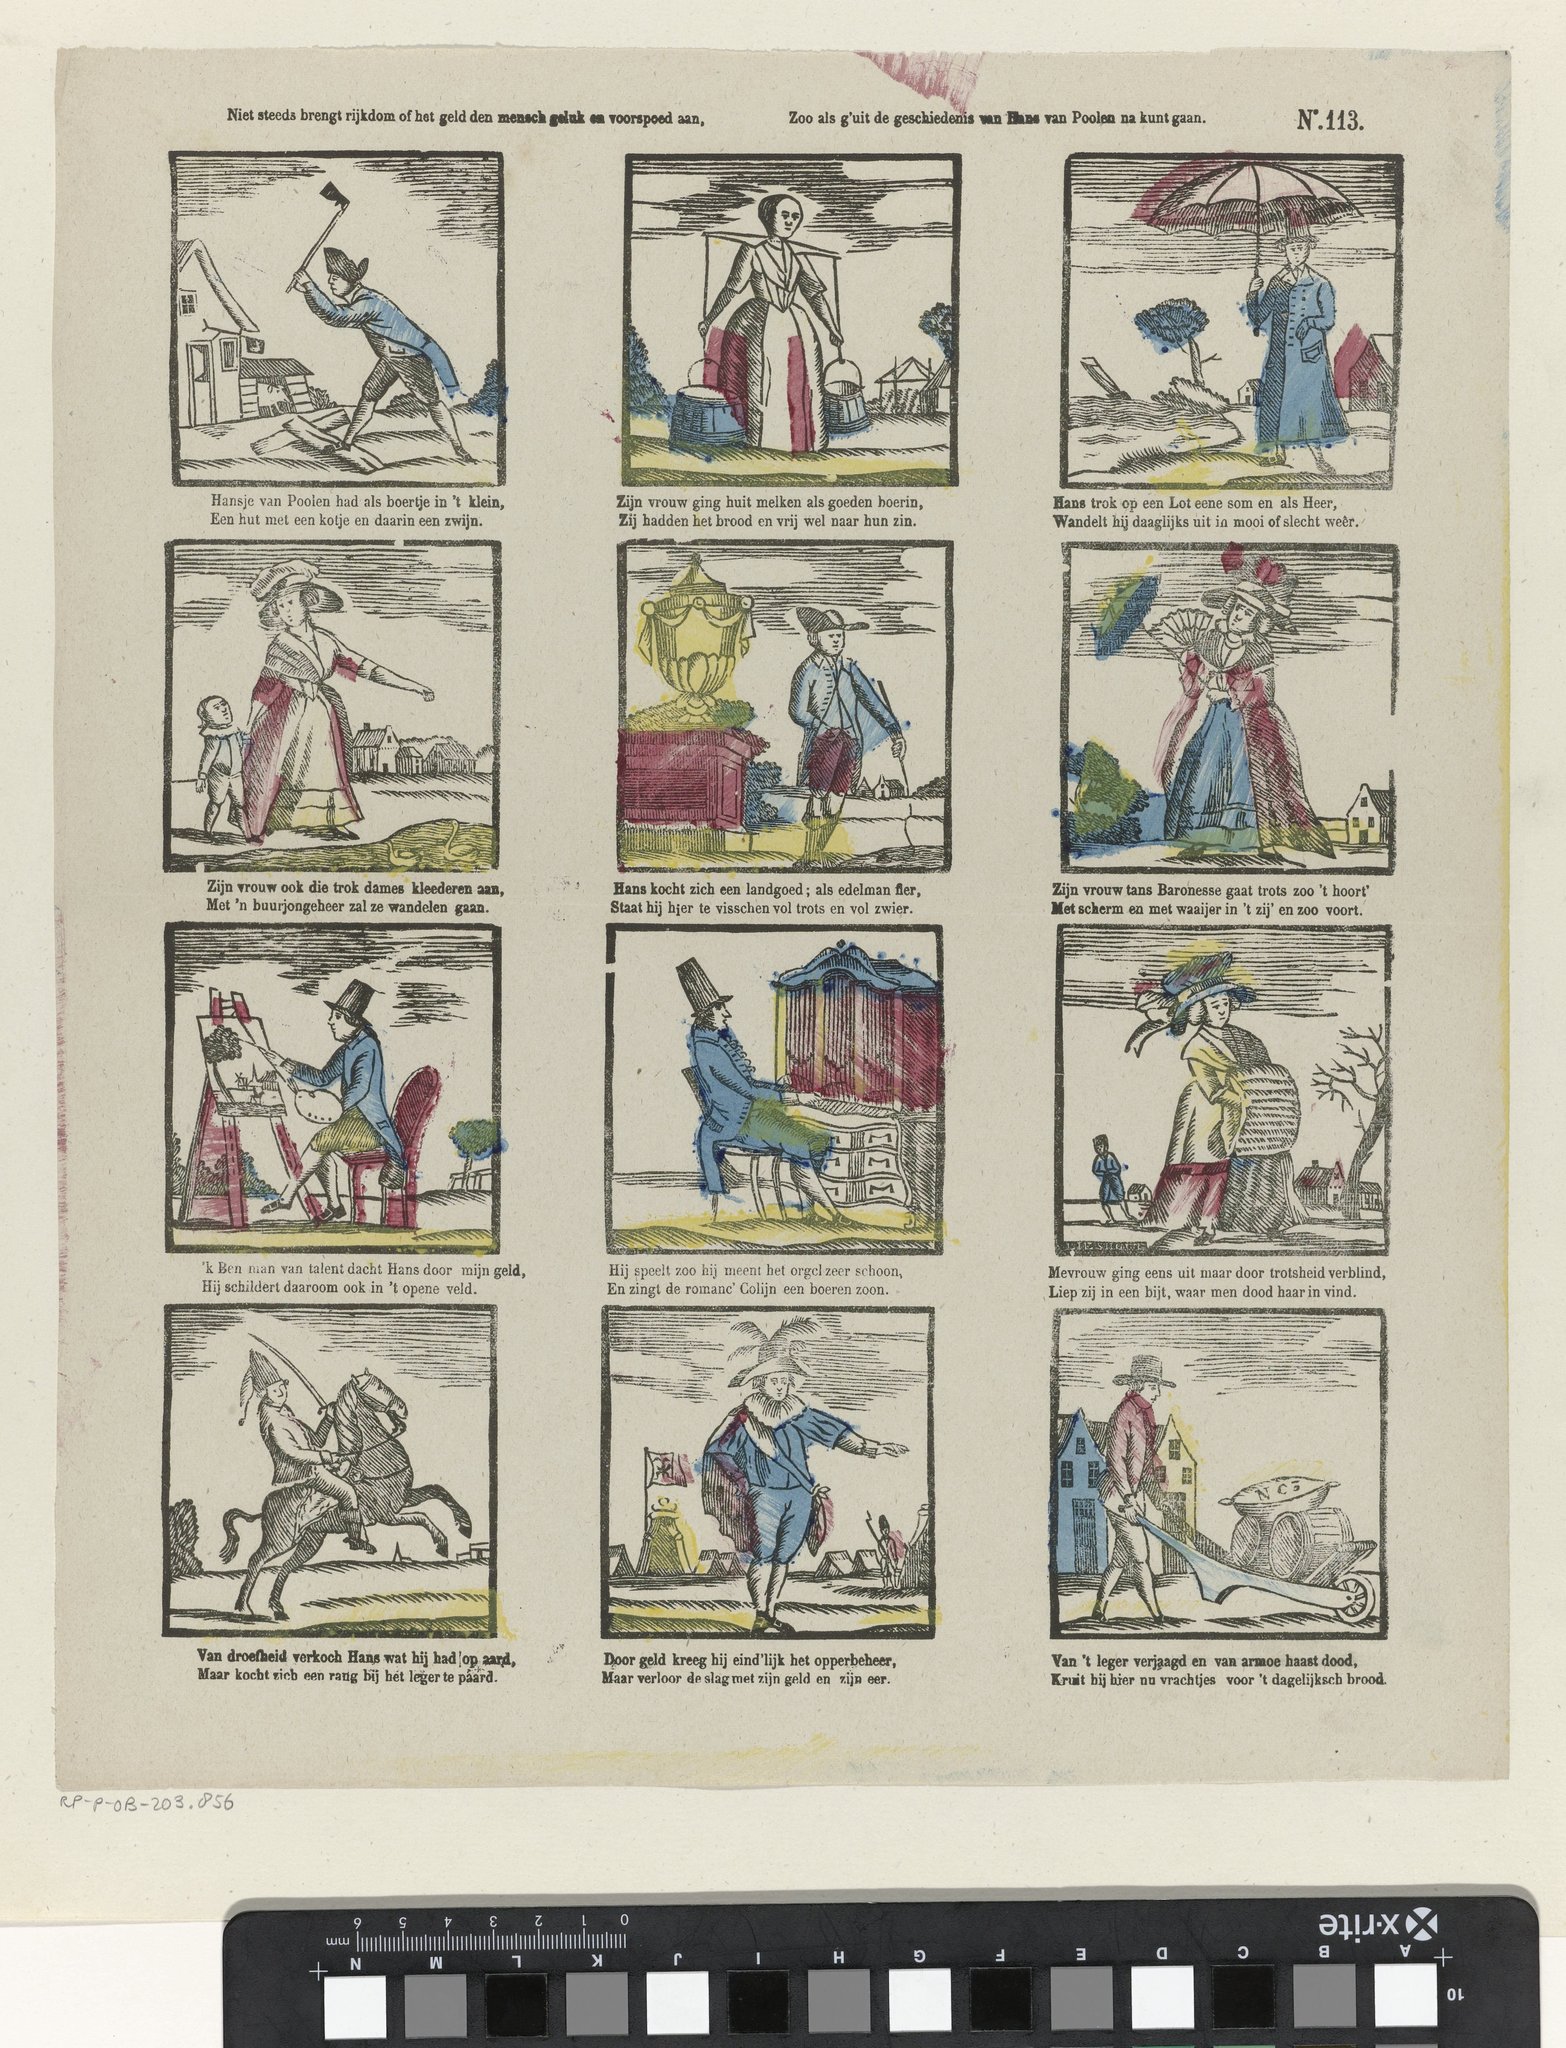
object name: print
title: Niet steeds brengt rijkdom of het geld den mensch geluk en voorspoed aan, / Zoo als g'uit de geschiedenis van Hans van Poolen na kunt gaan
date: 1827-1894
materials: paper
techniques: colour, letterpress printing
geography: schaarbeek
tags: farmers, the rich, contrast between rich and poor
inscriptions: collector's mark: Lugt 2760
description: Blad met 12 voorstellingen over het leven van Hansje van Poolen en zijn vrouw die steeds rijker worden. Onder elke afbeelding een tweeregelig vers. Genummerd rechtsboven: No. 113.